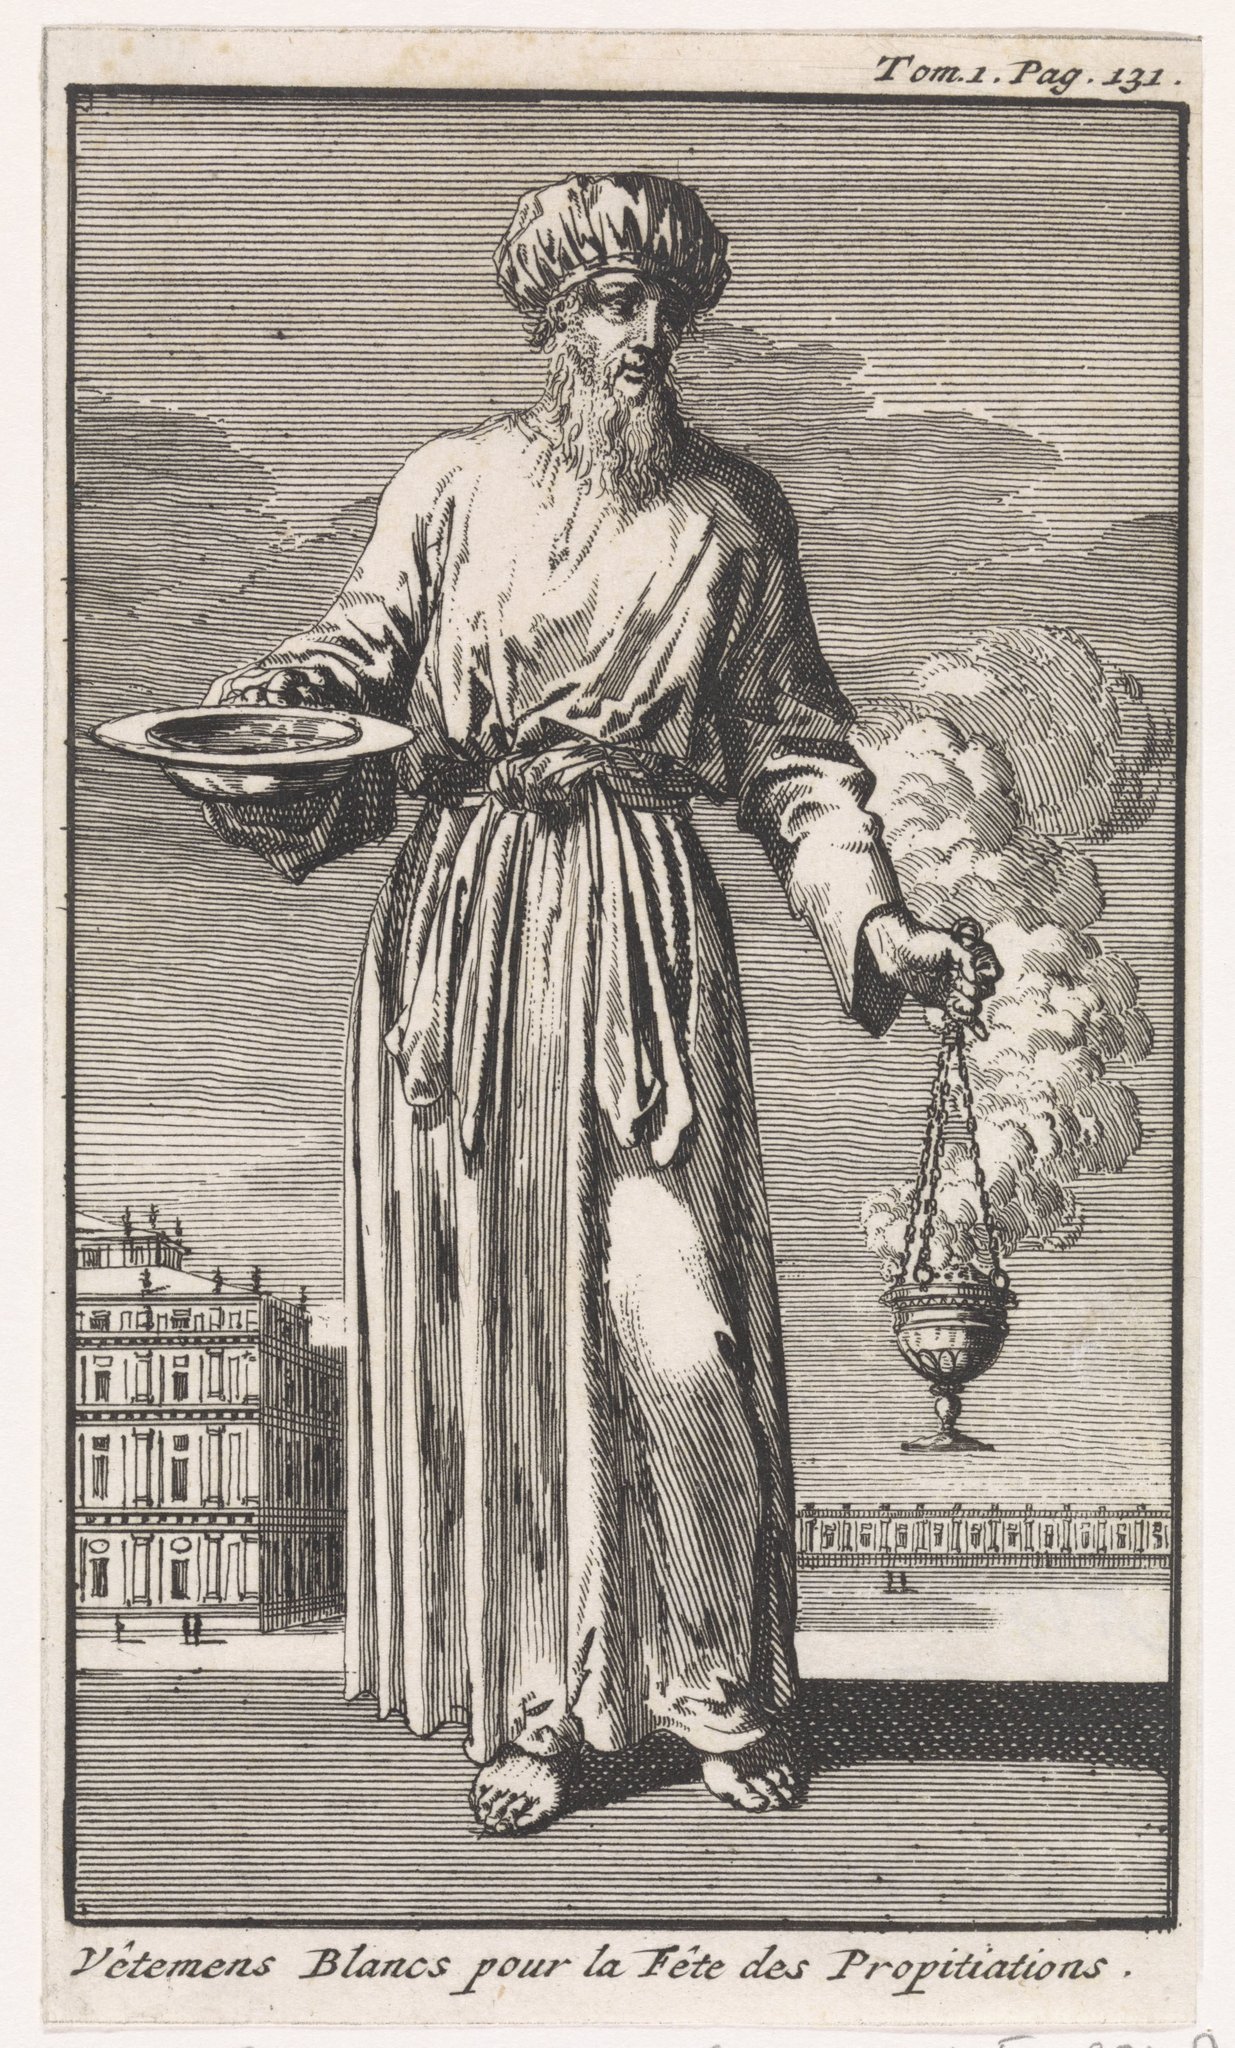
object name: print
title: Hogepriester in witte liturgische kleding behorend bij de Grote Verzoendag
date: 1705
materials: paper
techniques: etching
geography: amsterdam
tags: high priest ~ hierarchy of priests, 'yom kippur', day of atonement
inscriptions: collector's mark: Lugt 2228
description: Illustratie uit: Cunaeus, Petrus. La republique des Hebreux, 3 delen. Amsterdam: Pieter Mortier, 1705, dl. I, p. 131.